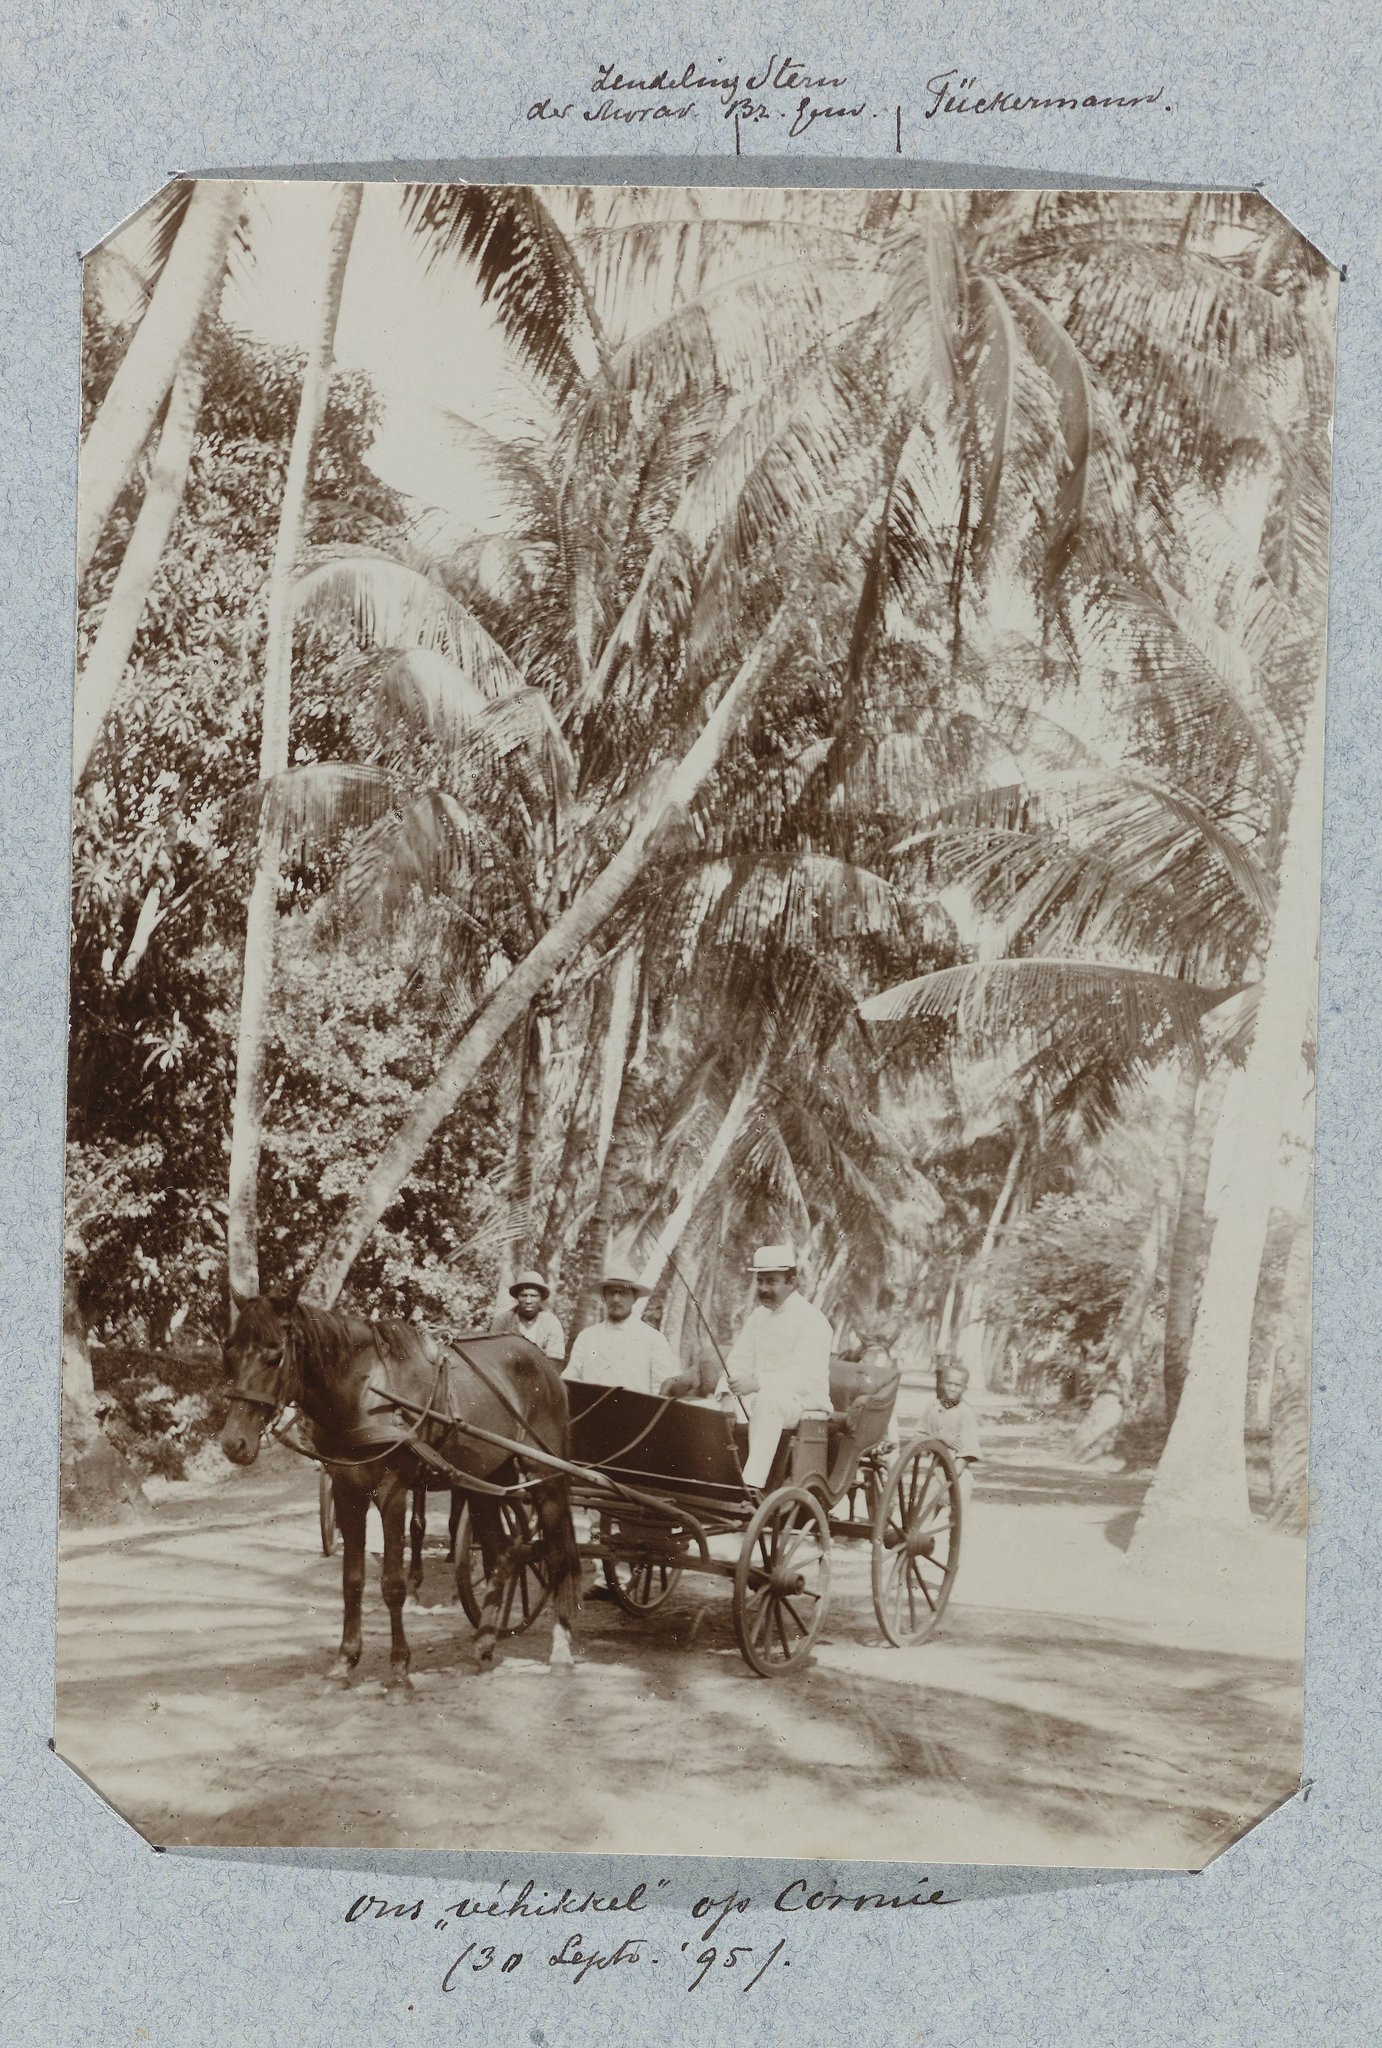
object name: photograph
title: Ons "véhikel" op Coronie (30 Sept. '95)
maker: théodore van lelyveld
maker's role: painter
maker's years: 1867-1954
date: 1895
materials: photographic support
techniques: collodion silver print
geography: suriname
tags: four-wheeled vehicle drawn by one animal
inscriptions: inscription: ‘Ons "véhikel" op Coronie (30 Sept. '95) / Zendeling Stern der Morav. Br. Gem. / Tückermann’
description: Rijtuig met koetsier waarmee Lelyveld te Coronie is gereisd. In de rijtuig een zendeling van de Moravische Broedergemeente. Fotoafdruk in een fotoalbum van Théodore van Lelyveld over Suriname uit 1895-1898.